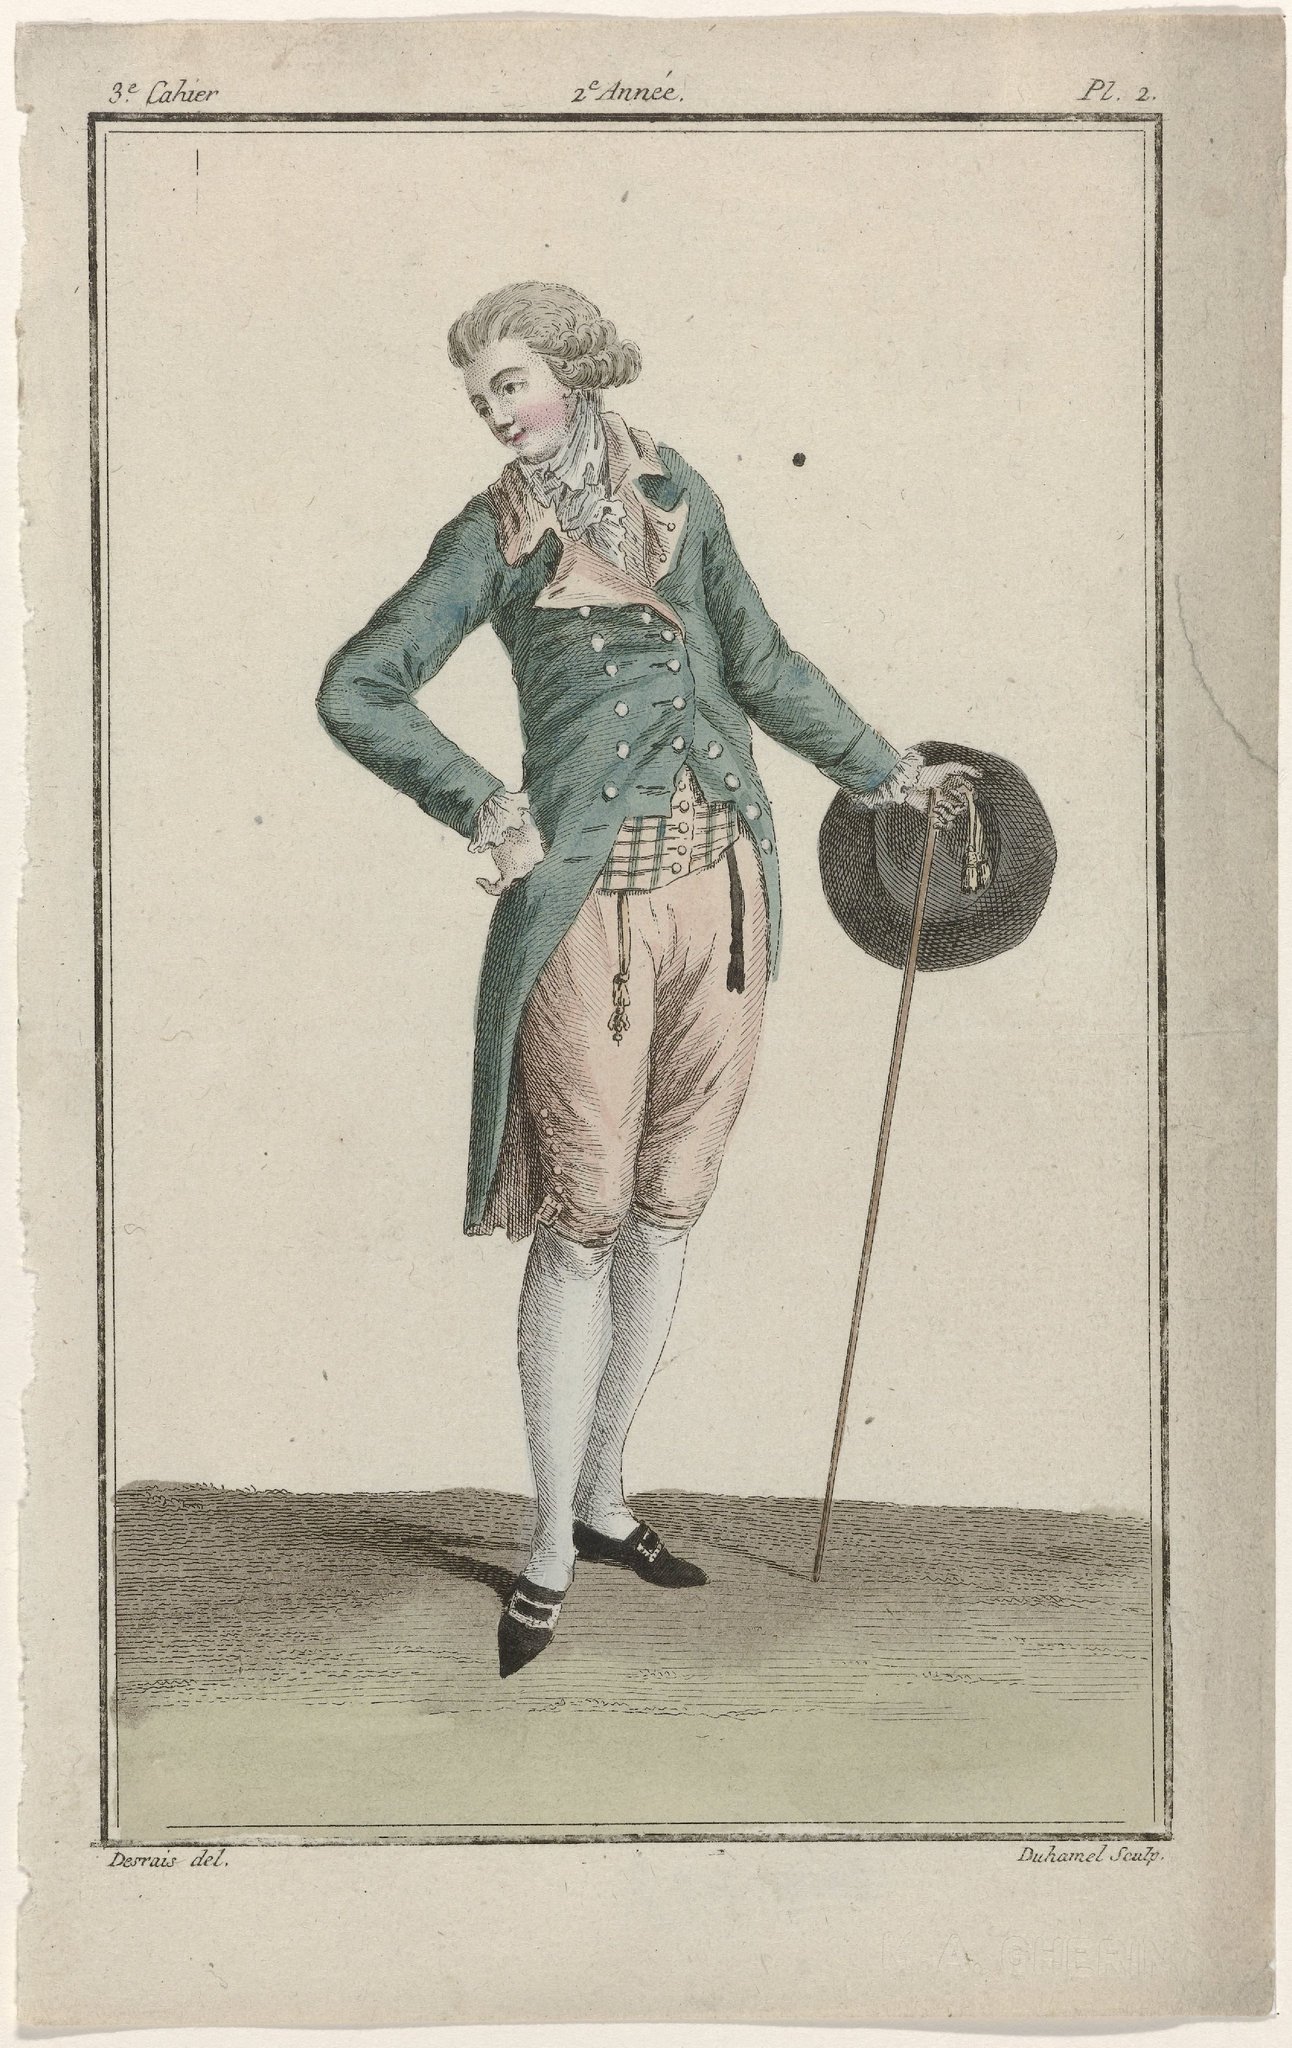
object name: fashion print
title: Magasin des Modes Nouvelles Françaises et Anglaises, 10 décembre 1786, 2e Année, 3e cahier, Pl. 2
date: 1786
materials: paper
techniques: engraving, hand coloring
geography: paris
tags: clothing for the upper part of the body (vest) (+ men's clothes), coat (frac) (+ men's clothes), head-gear: hat (+ men's clothes), fashion plates, shoes, sandals (+ men's clothes), trousers, breeches, etc. (breeches) (+ men's clothes), stockings, socks (+ men's clothes), walking-stick, staff, cane (+ men's clothes)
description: Staande jongeman gekleed in een frak van groen satijn met een dubbele rij knopen. Hij draagt een halsdoek, geruit vest, kniebroek en kousen. Gerimpelde jabot en manchetten. Accessoires: hoed, wandelstok met lint en kwasten, breloques, schoenen met gespen. De prent maakt deel uit van het 2e Année, 3e Cahier, uit de serie Magasin des Modes Nouvelles Françaises et Anglaises . De serie bestaat uit 172 modeprenten, uitgegeven door Buisson, Parijs, 20 novembre 1786 - 21 décembre 1789.